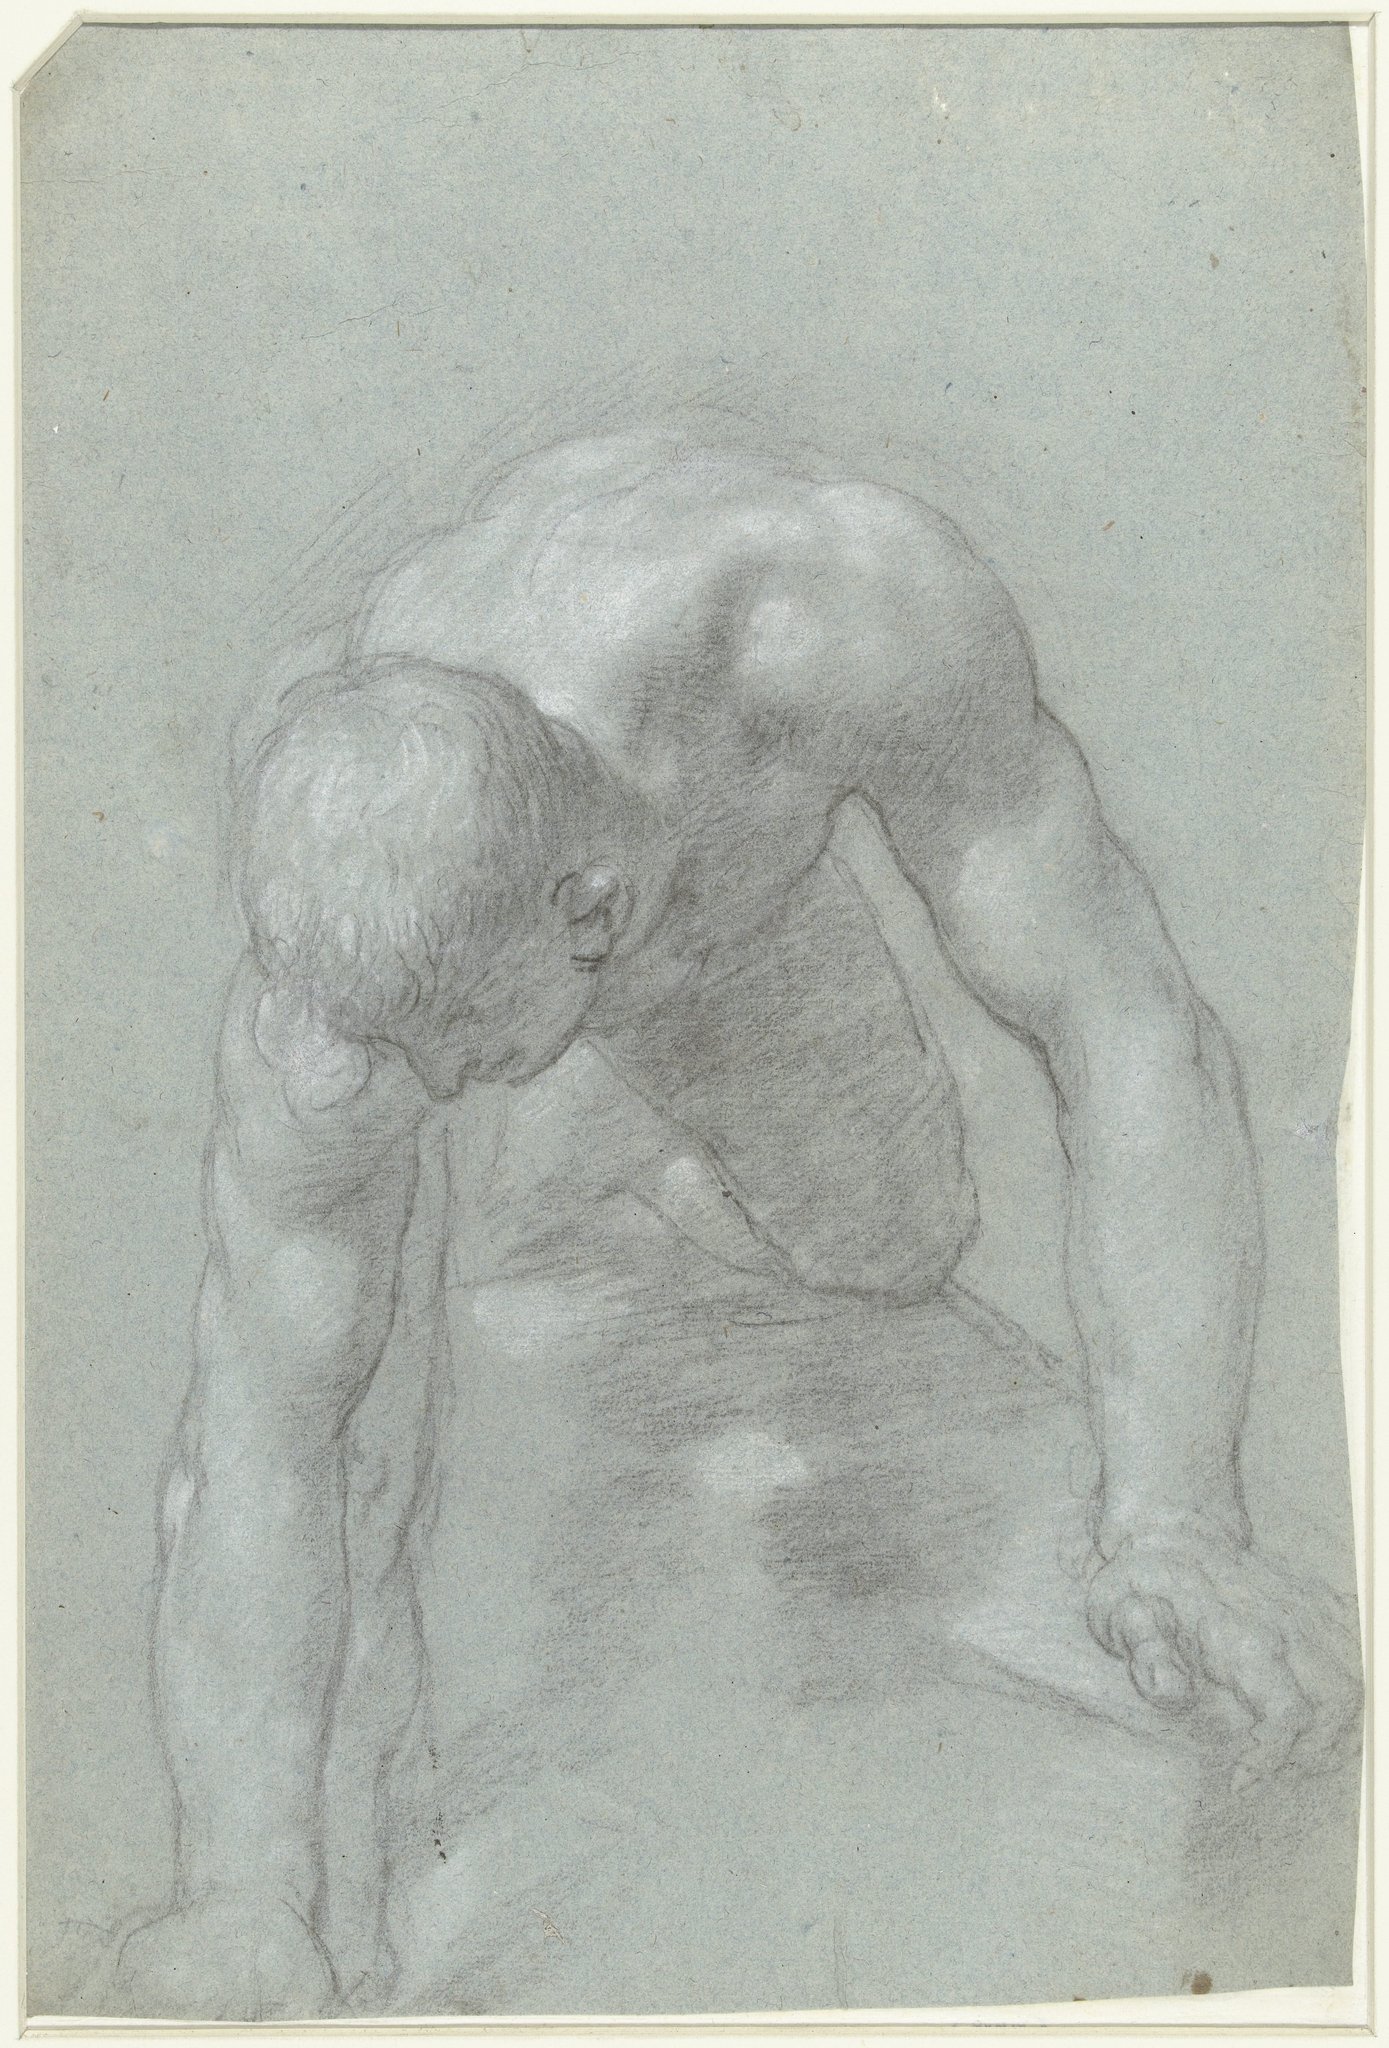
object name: drawing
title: Vooroverbuigende mansfiguur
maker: Anonymous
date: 1600-1699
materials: chalk, paper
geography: verona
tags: kneeling figure